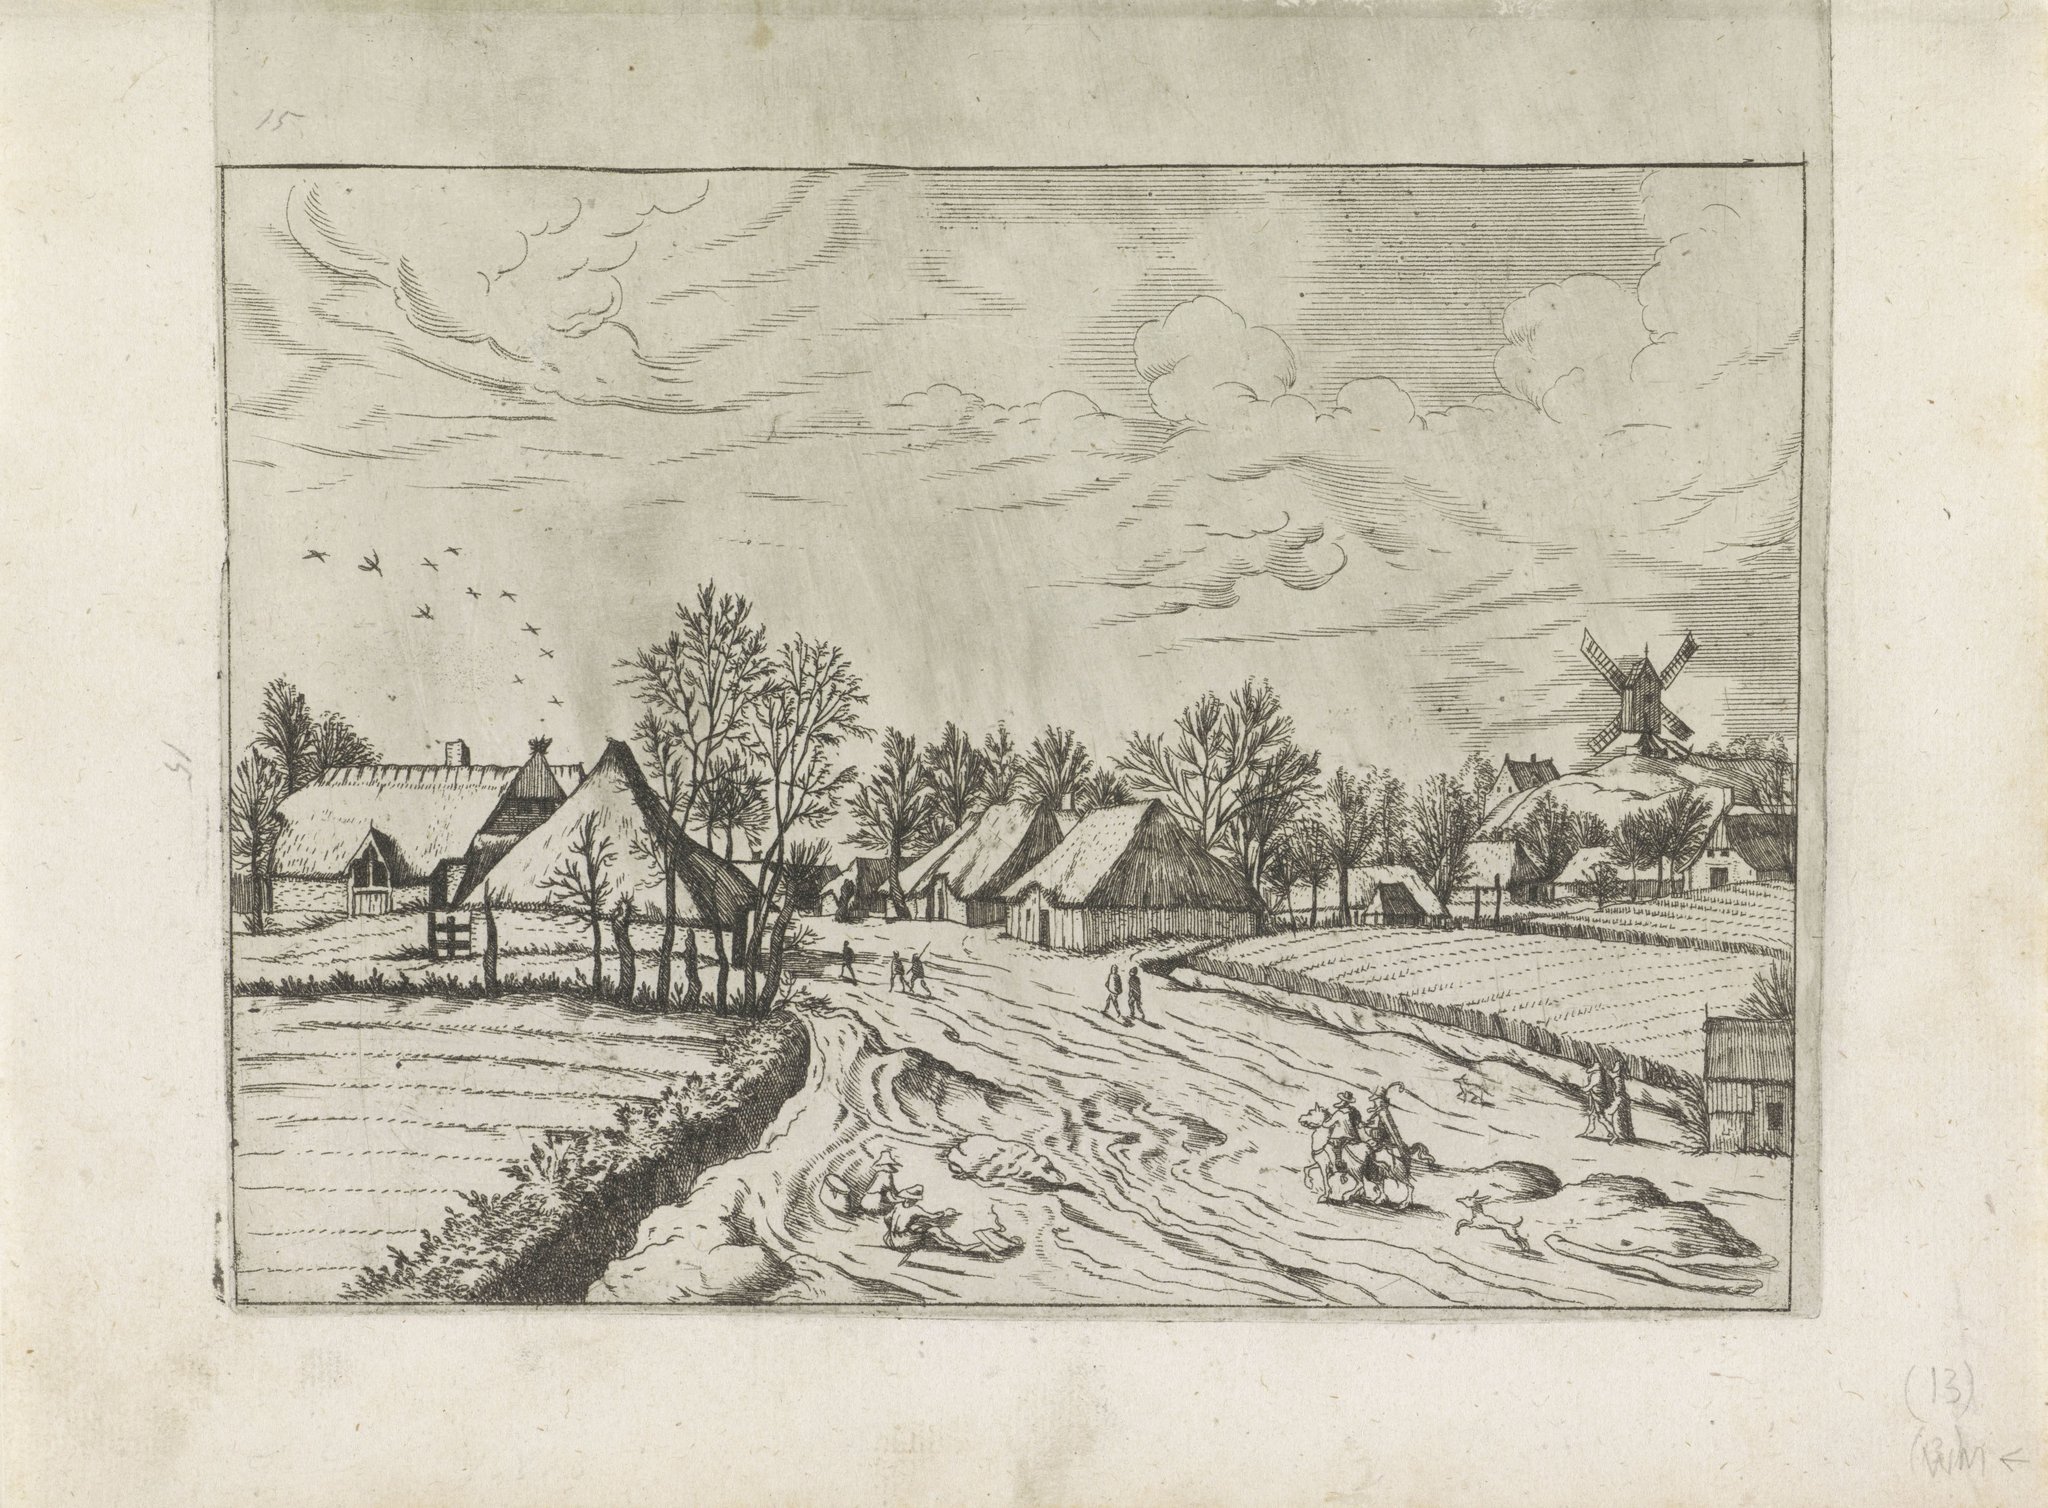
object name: print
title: Dorp met windmolen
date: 1559-1561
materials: paper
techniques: etching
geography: antwerp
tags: windmill, farm (building)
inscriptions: collector's mark: Lugt 2228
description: Gezicht op een dorp met rechts een windmolen. Op de voorgrond op de weg ruiters en voetgangers.